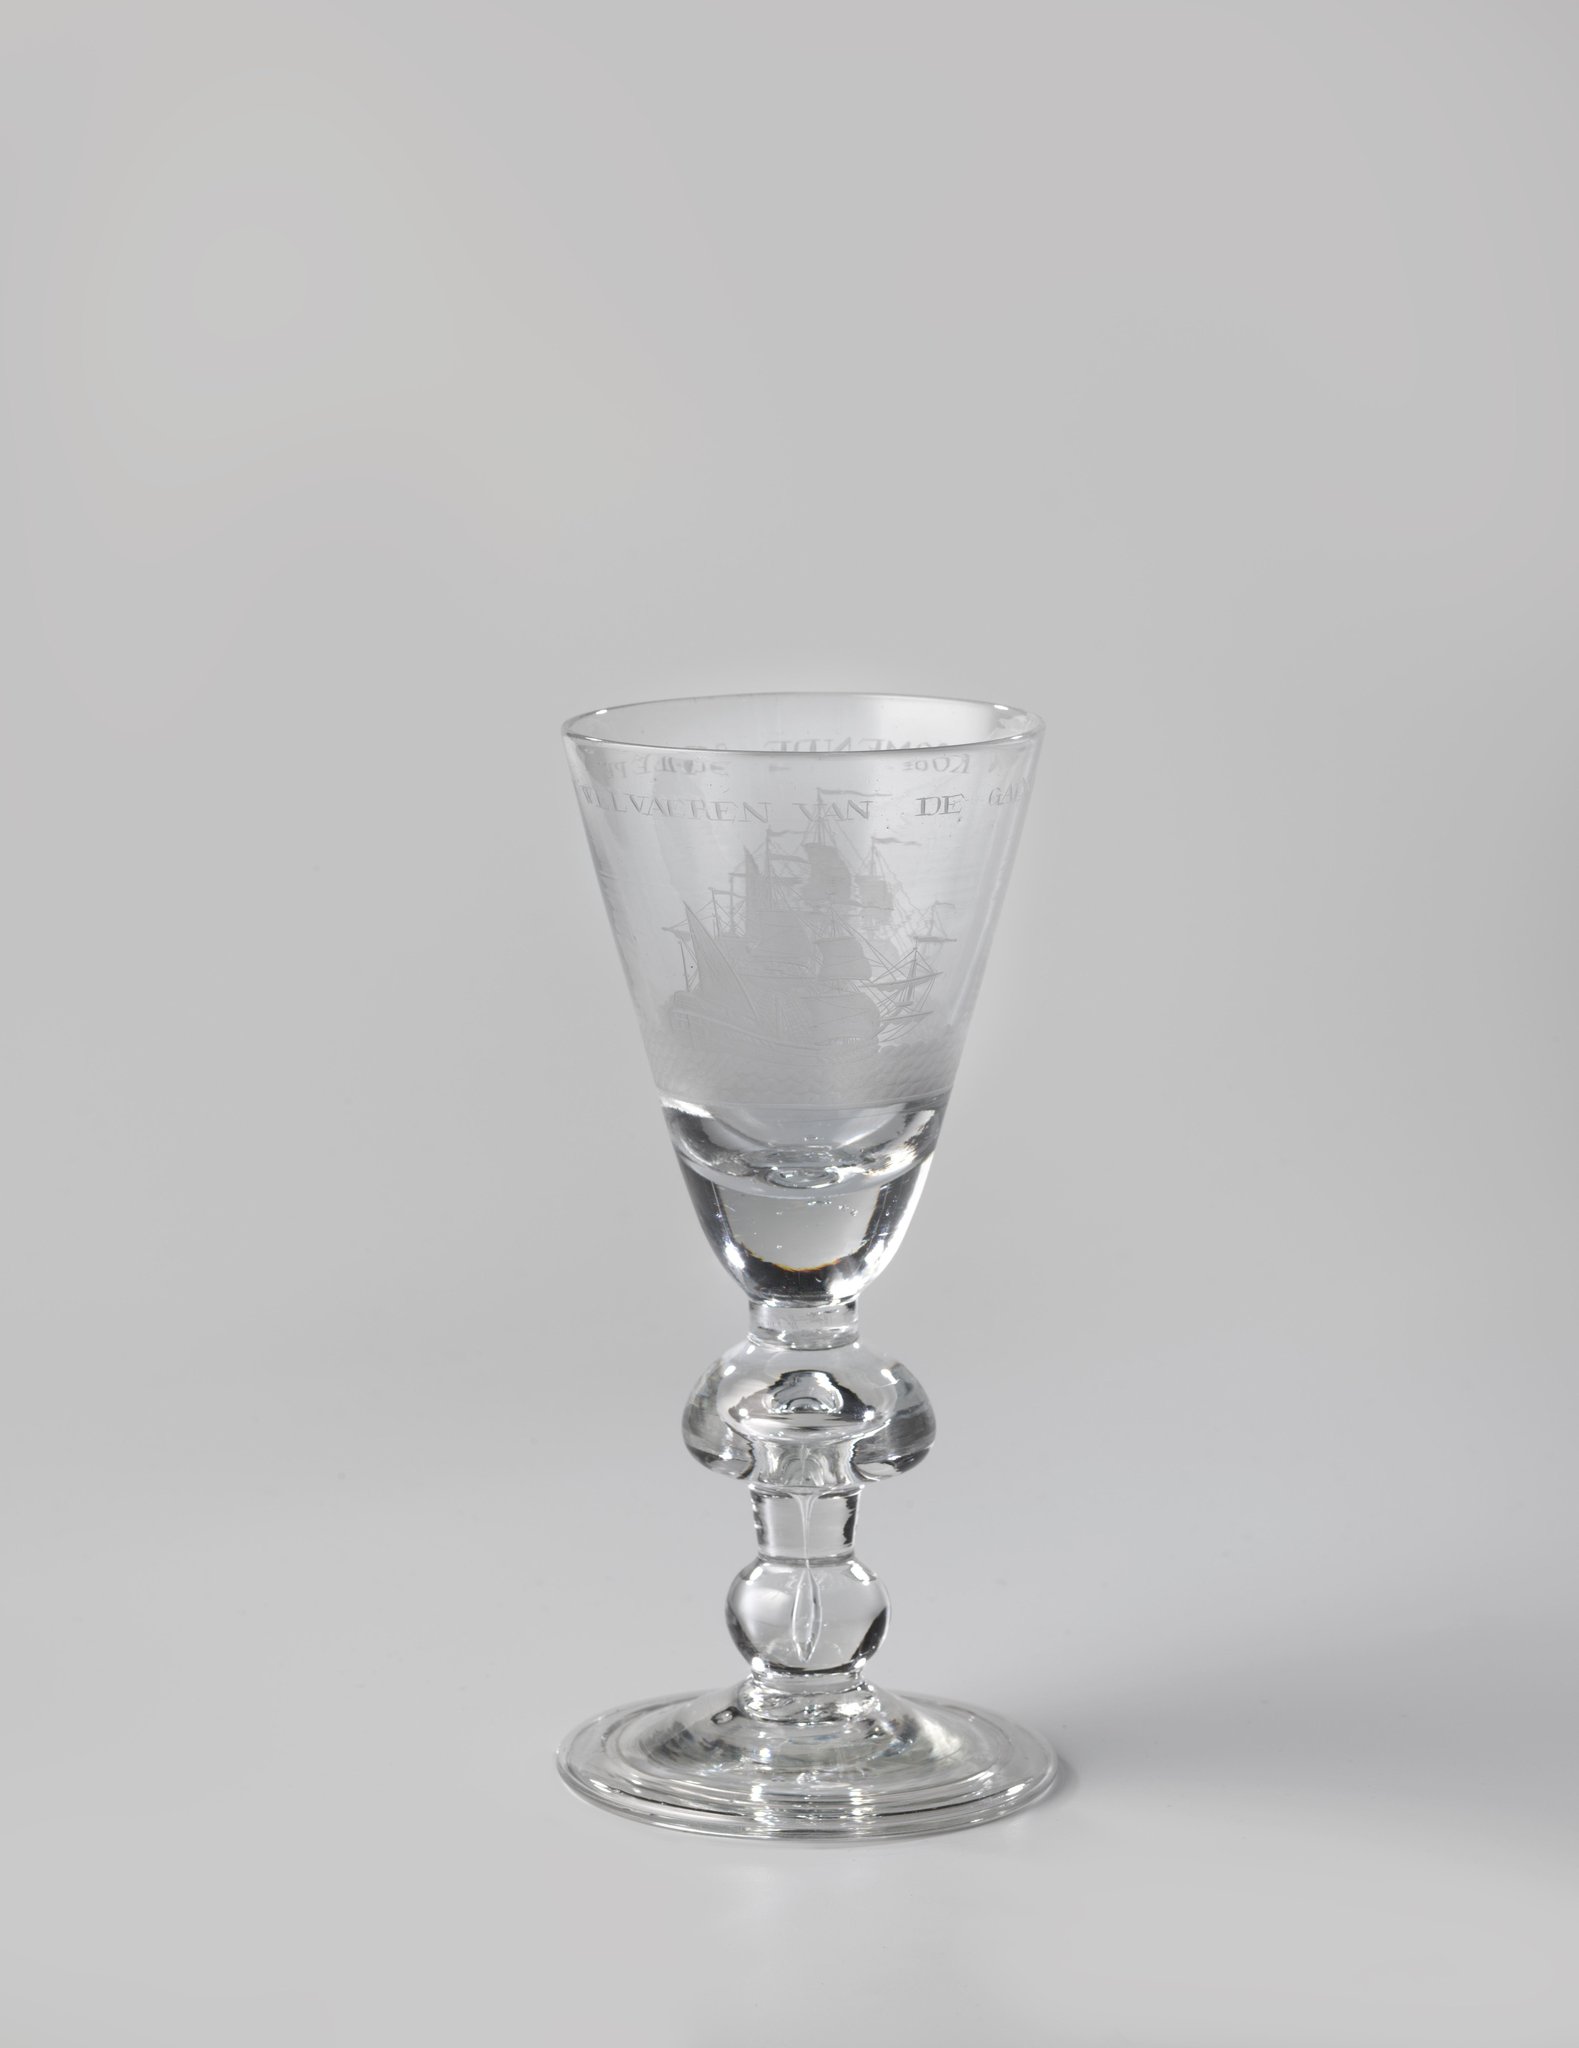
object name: goblet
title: Bokaal met het opschrift: T WELVAEREN VAN DE GAENDE EN KOOMENDE SCHEEPE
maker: Anonymous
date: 1700-1725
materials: glass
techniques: glassblowing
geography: northern netherlands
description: Bokaal met een gegraveerde voorstelling van twee zeilende fregatten en het opschrift 't Welvaeren van de gaende en koomende scheepe. De kelk is conisch met een dikke massieve bodem. De stam is massief met luchtbel en twee knopen, waarvan de bovenste breed. Platte voet met omgeslagen rand.